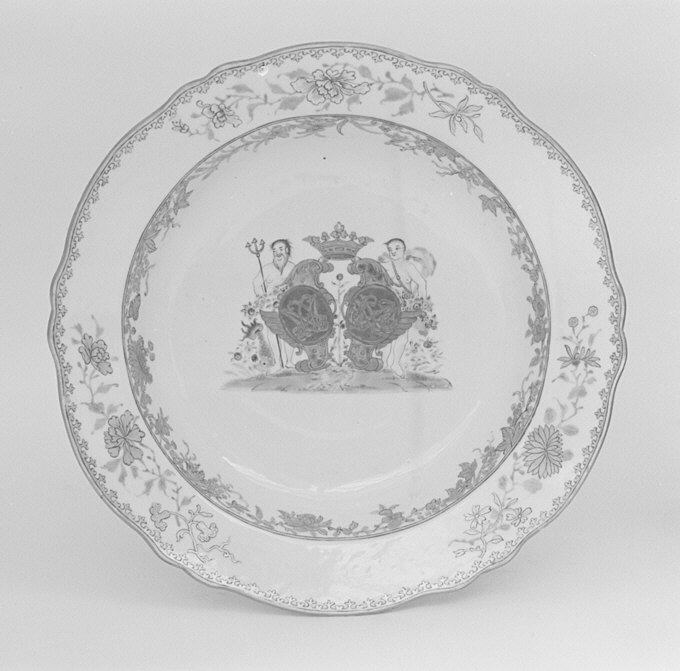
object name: soup plate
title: Soup plate (part of a service)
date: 1760-1770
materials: hard paste porcelain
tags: men,flowers,coat of arms